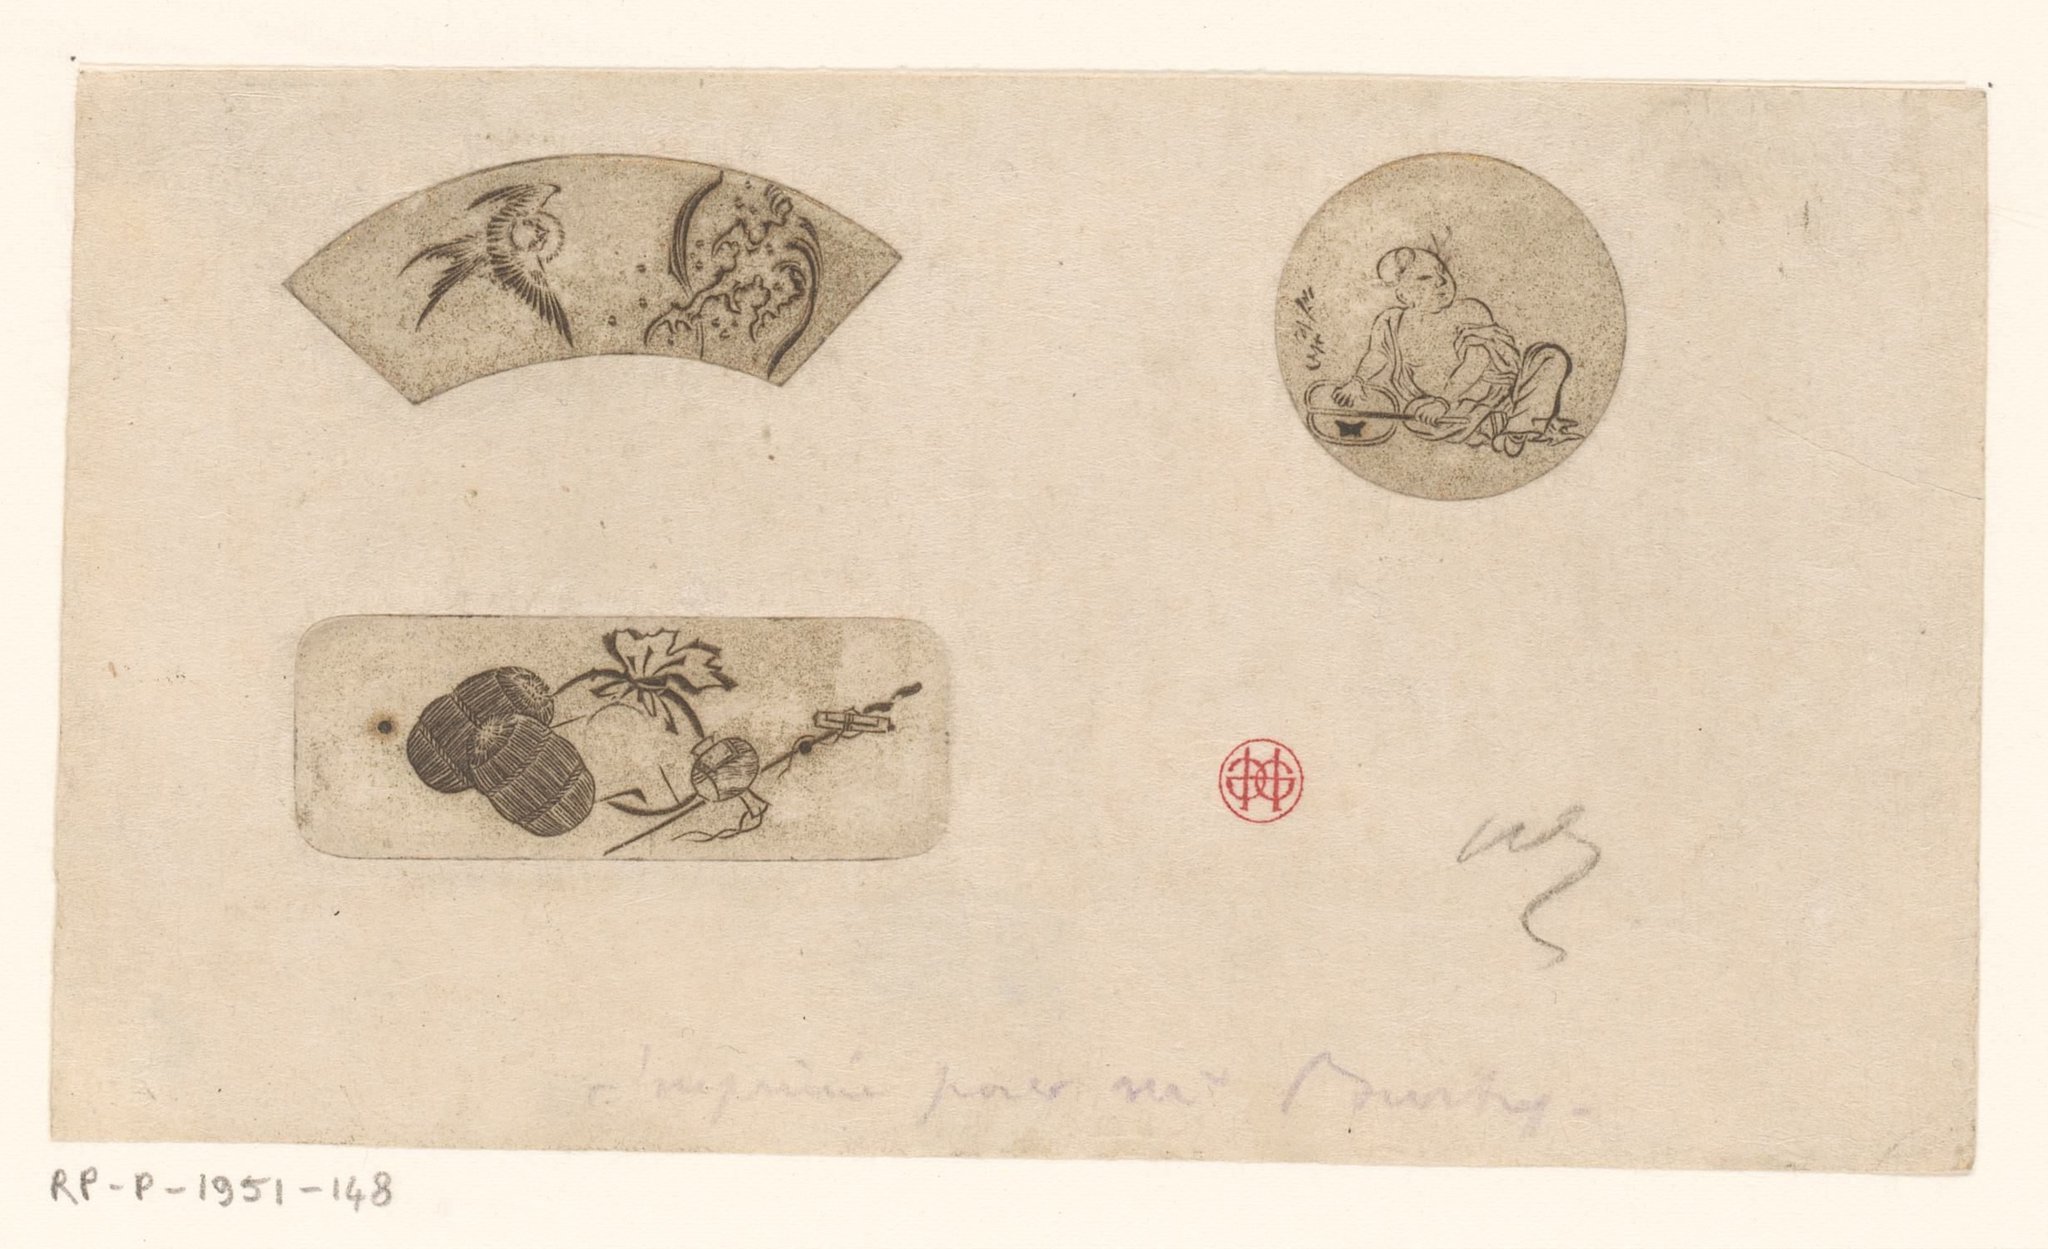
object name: print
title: Drie Japanse motieven, mogelijk waaiers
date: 1856-1897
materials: paper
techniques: etching, intaglio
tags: song-birds: swallow, fan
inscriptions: collector's mark: Lugt 2228, annotation: ‘imprimé pour m. Burty.’, stamp: Lugt 1157